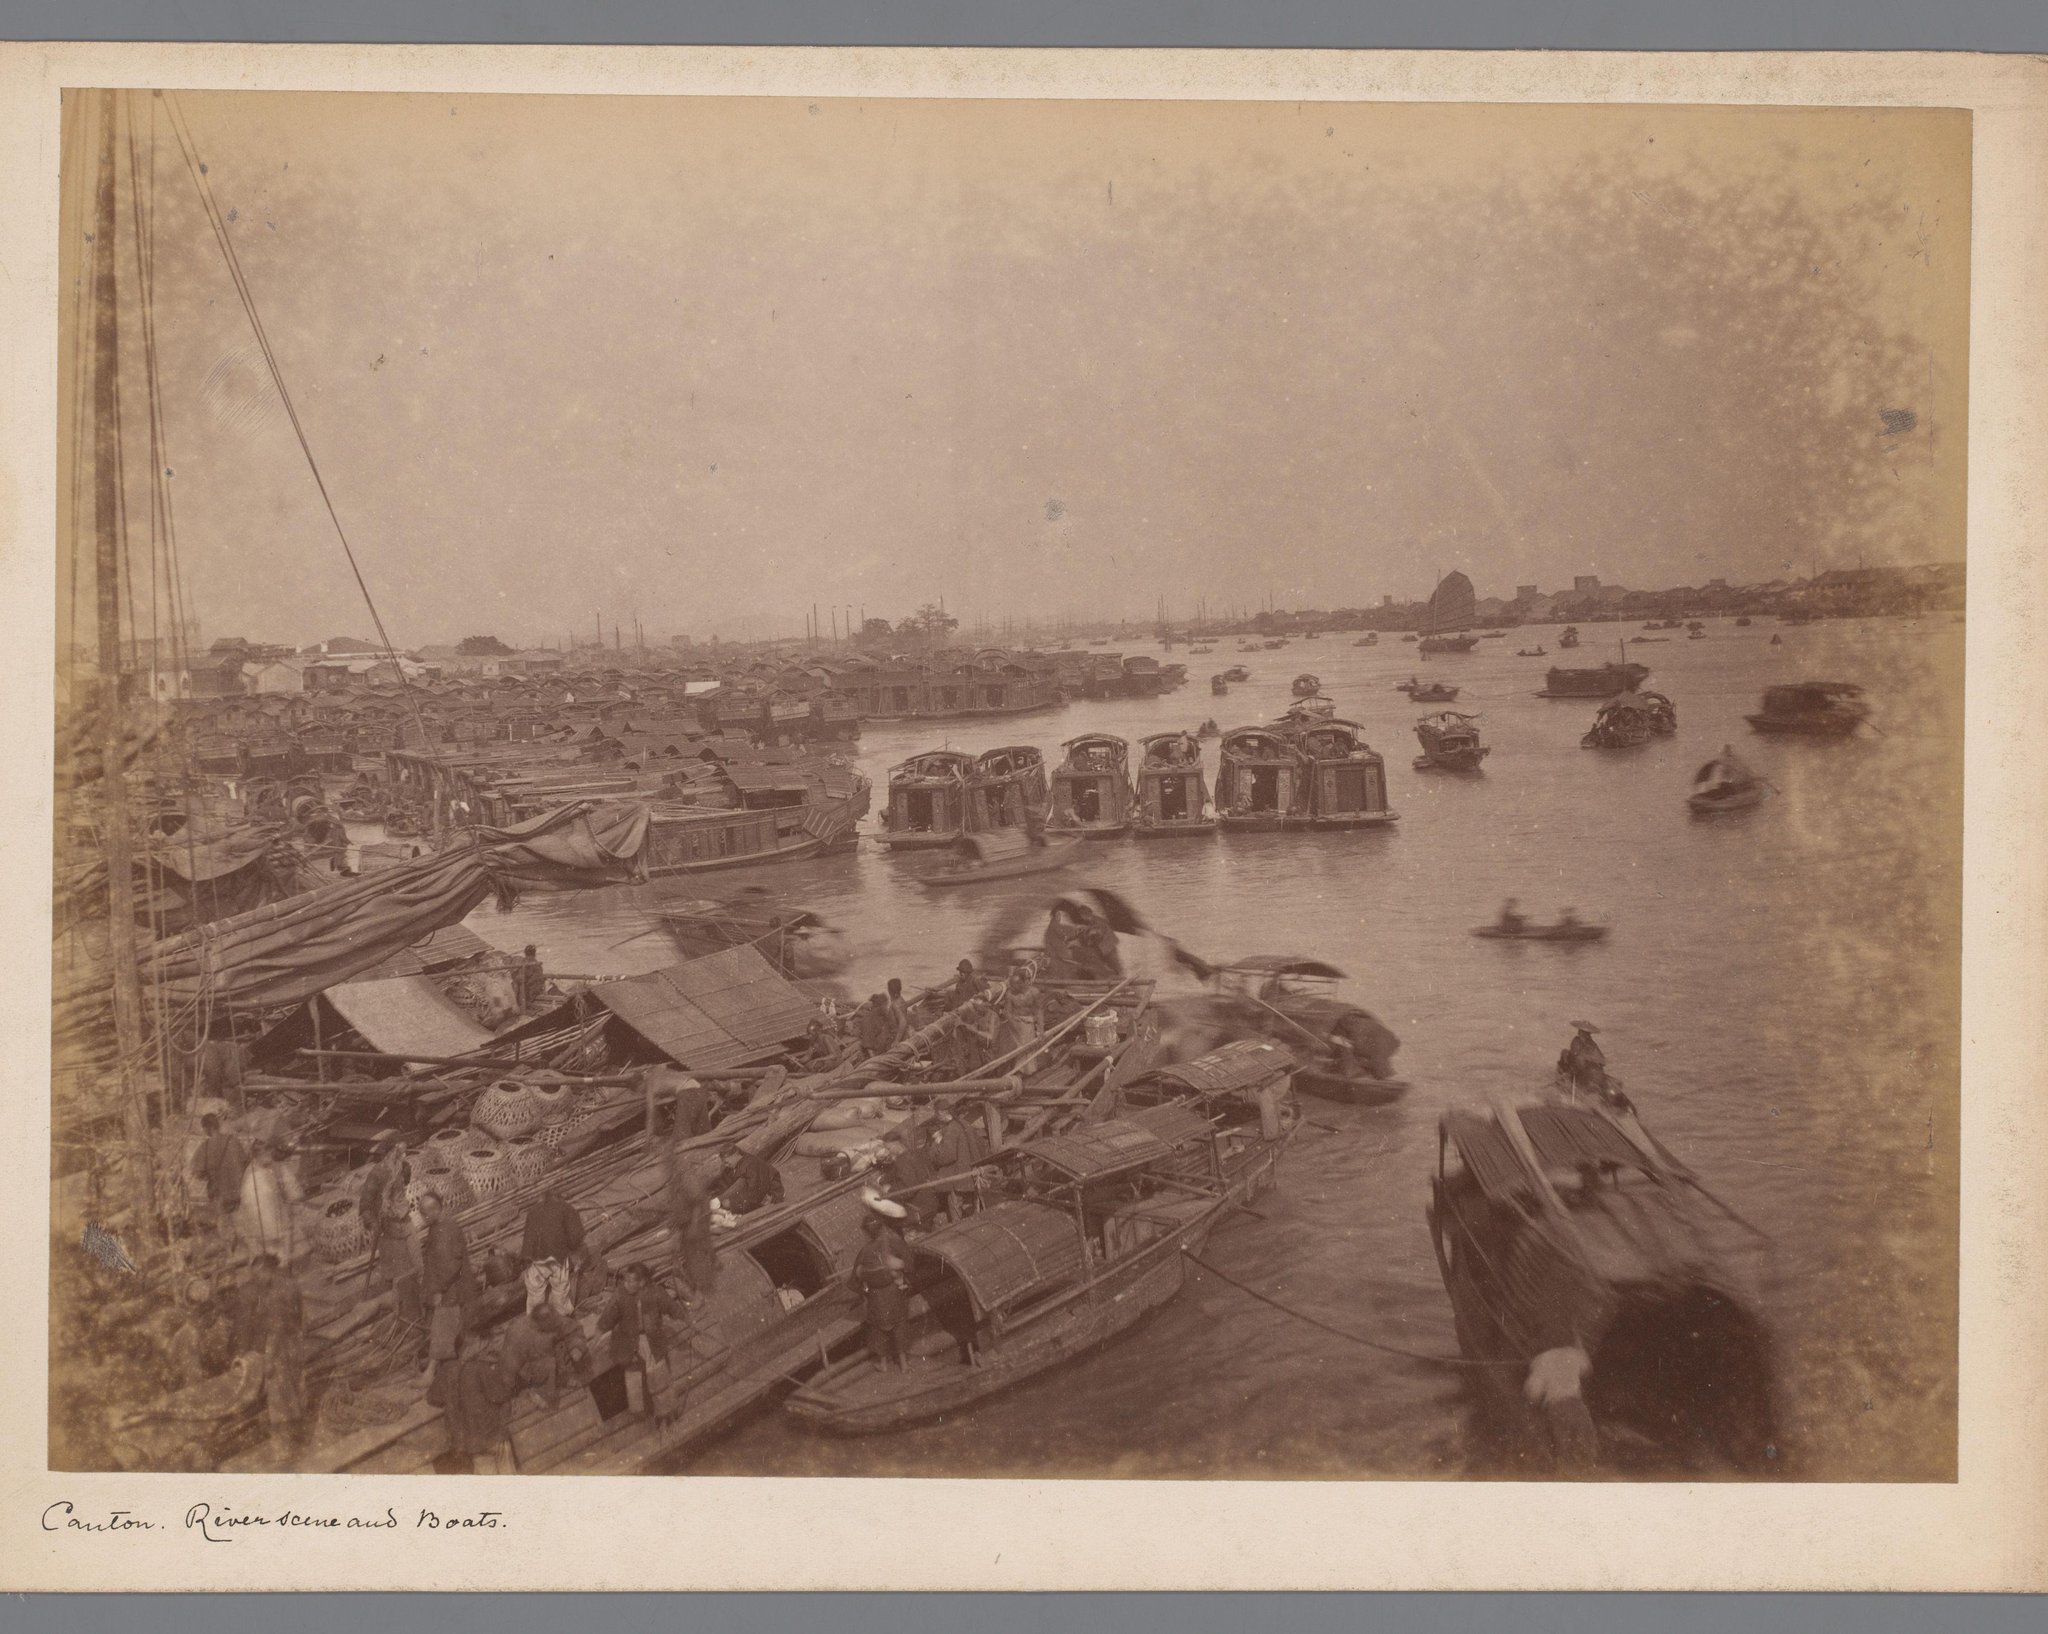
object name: photograph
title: Gezicht op de rivier met boten bij Guangzhou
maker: Anonymous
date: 1850-1900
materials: cardboard, photographic support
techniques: albumen print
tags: harbour, river (+ landscape with figures, staffage)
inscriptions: annotation: ‘Canton, Riverscene and boats’